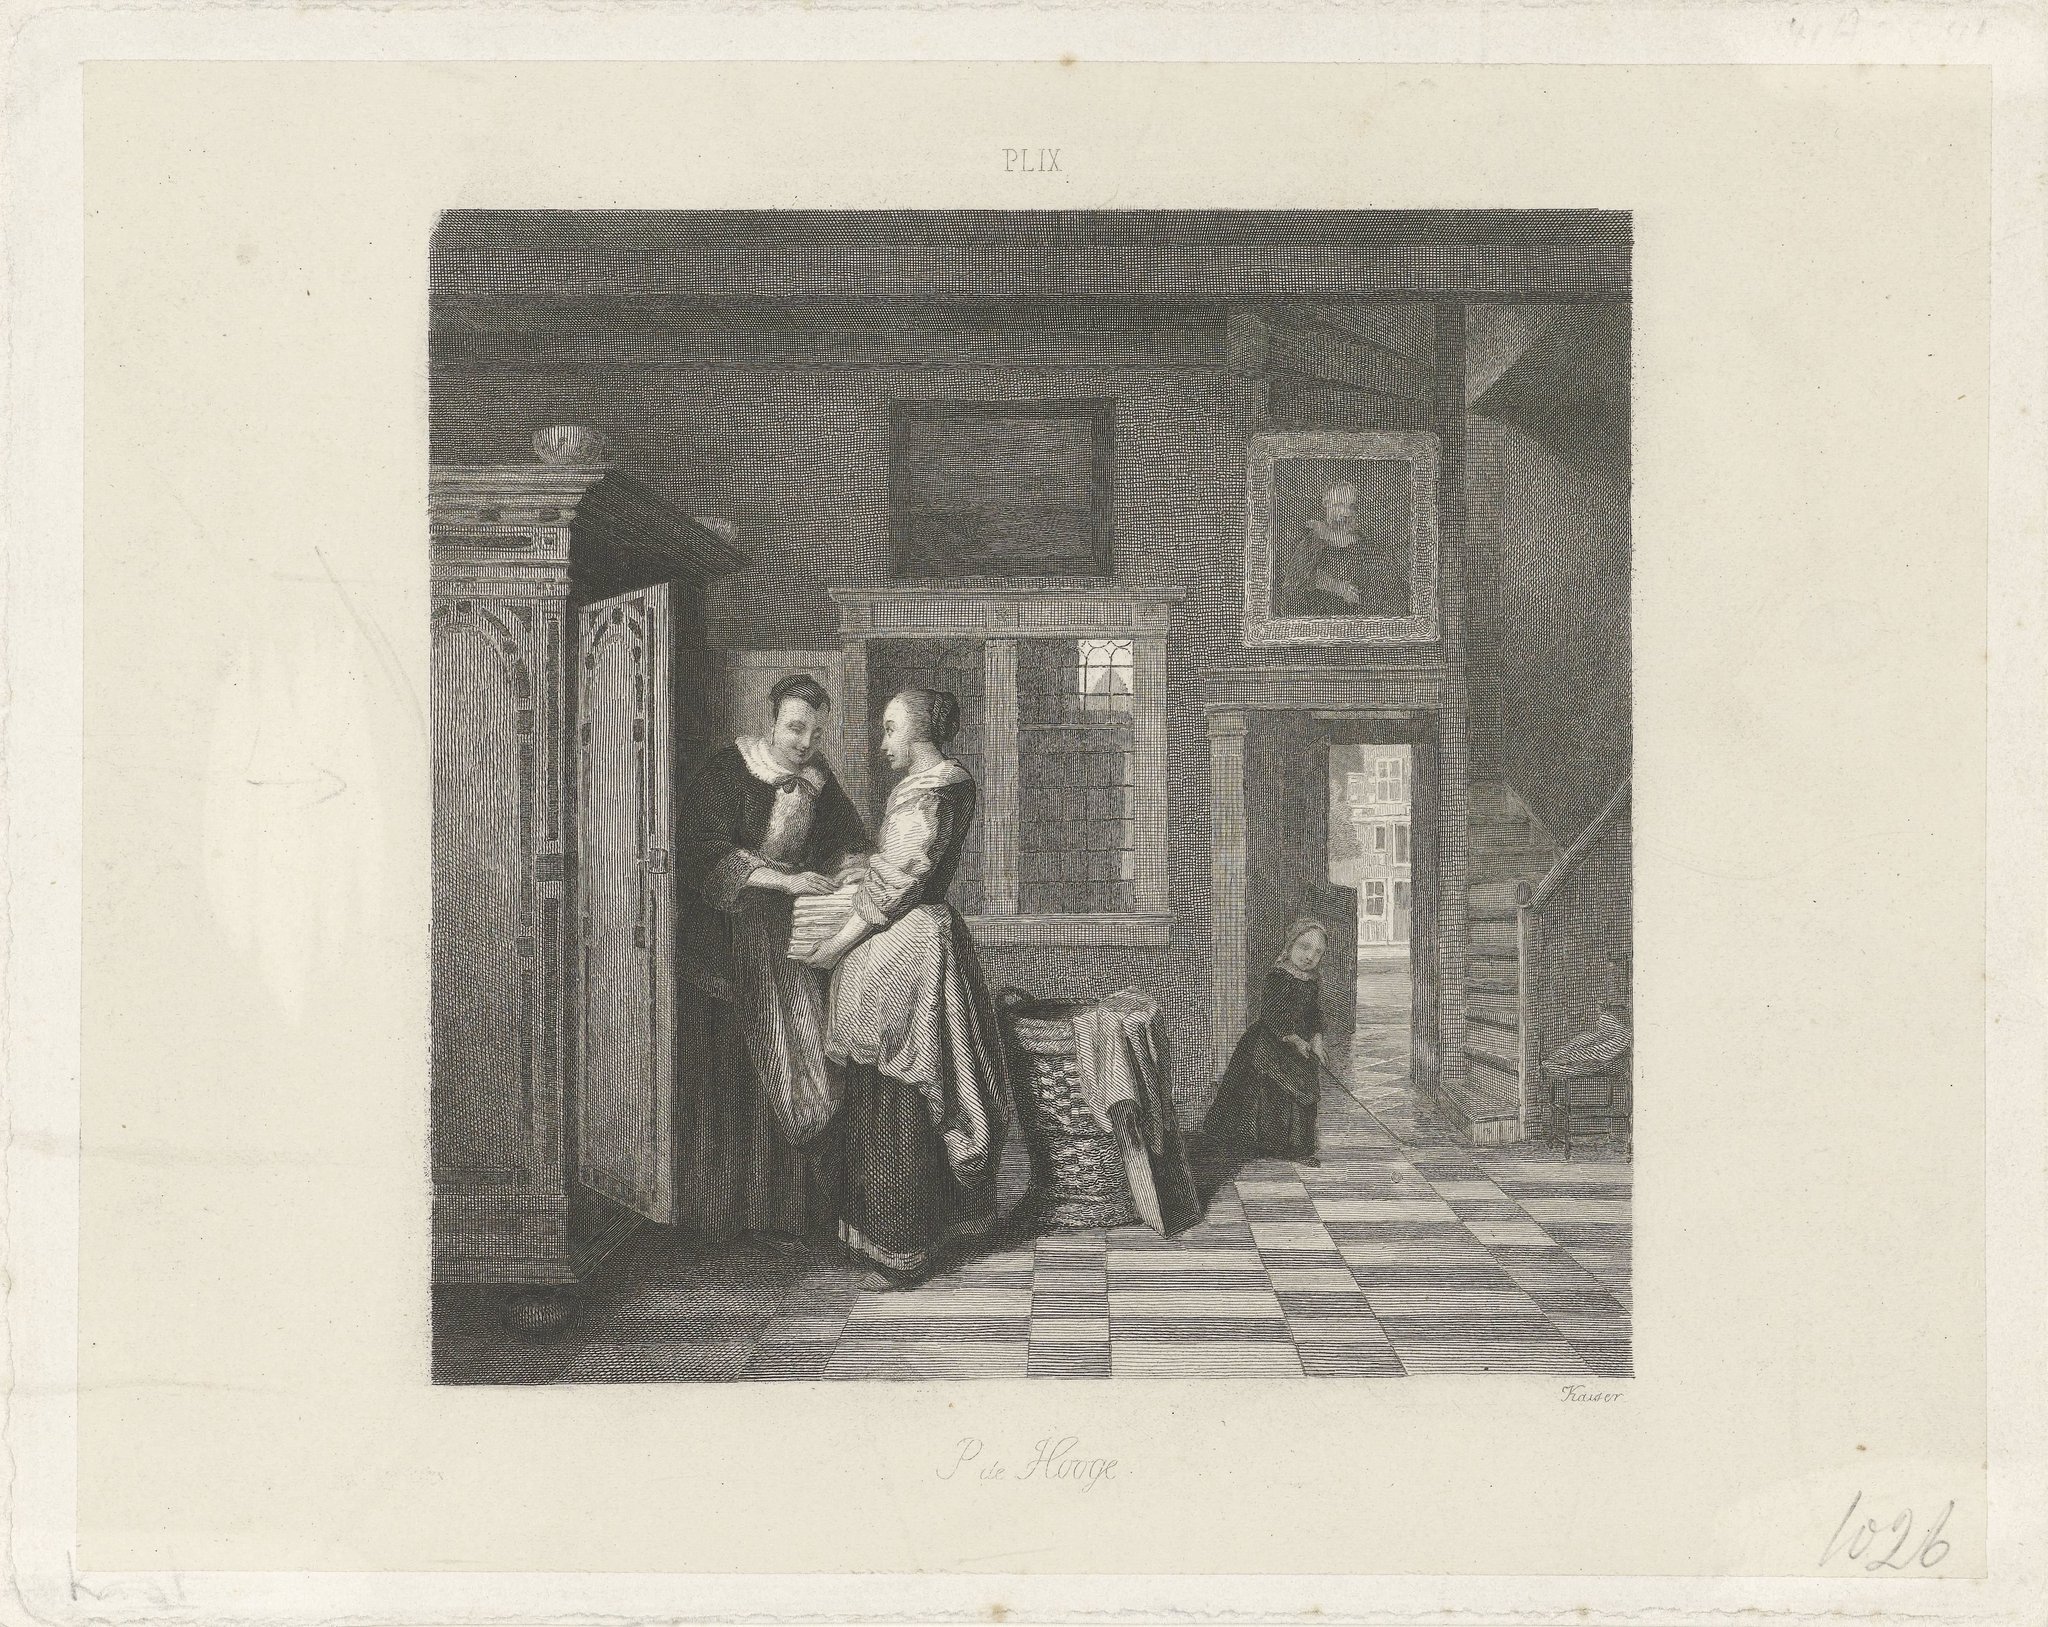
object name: print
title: Hollandse meesters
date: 1823-1900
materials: paper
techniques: etching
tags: care and laundering of clothes; home sewing, interior of the house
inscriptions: collector's mark: Lugt 2228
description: Interieur met twee vrouwen voor een geopende linnenkast. In de deuropening speelt een kind met een kolfstok en een balletje. De prent maakt deel uit van een serie van 25 prenten naar Hollandse meesters. Boven de afbeelding: PL IX.